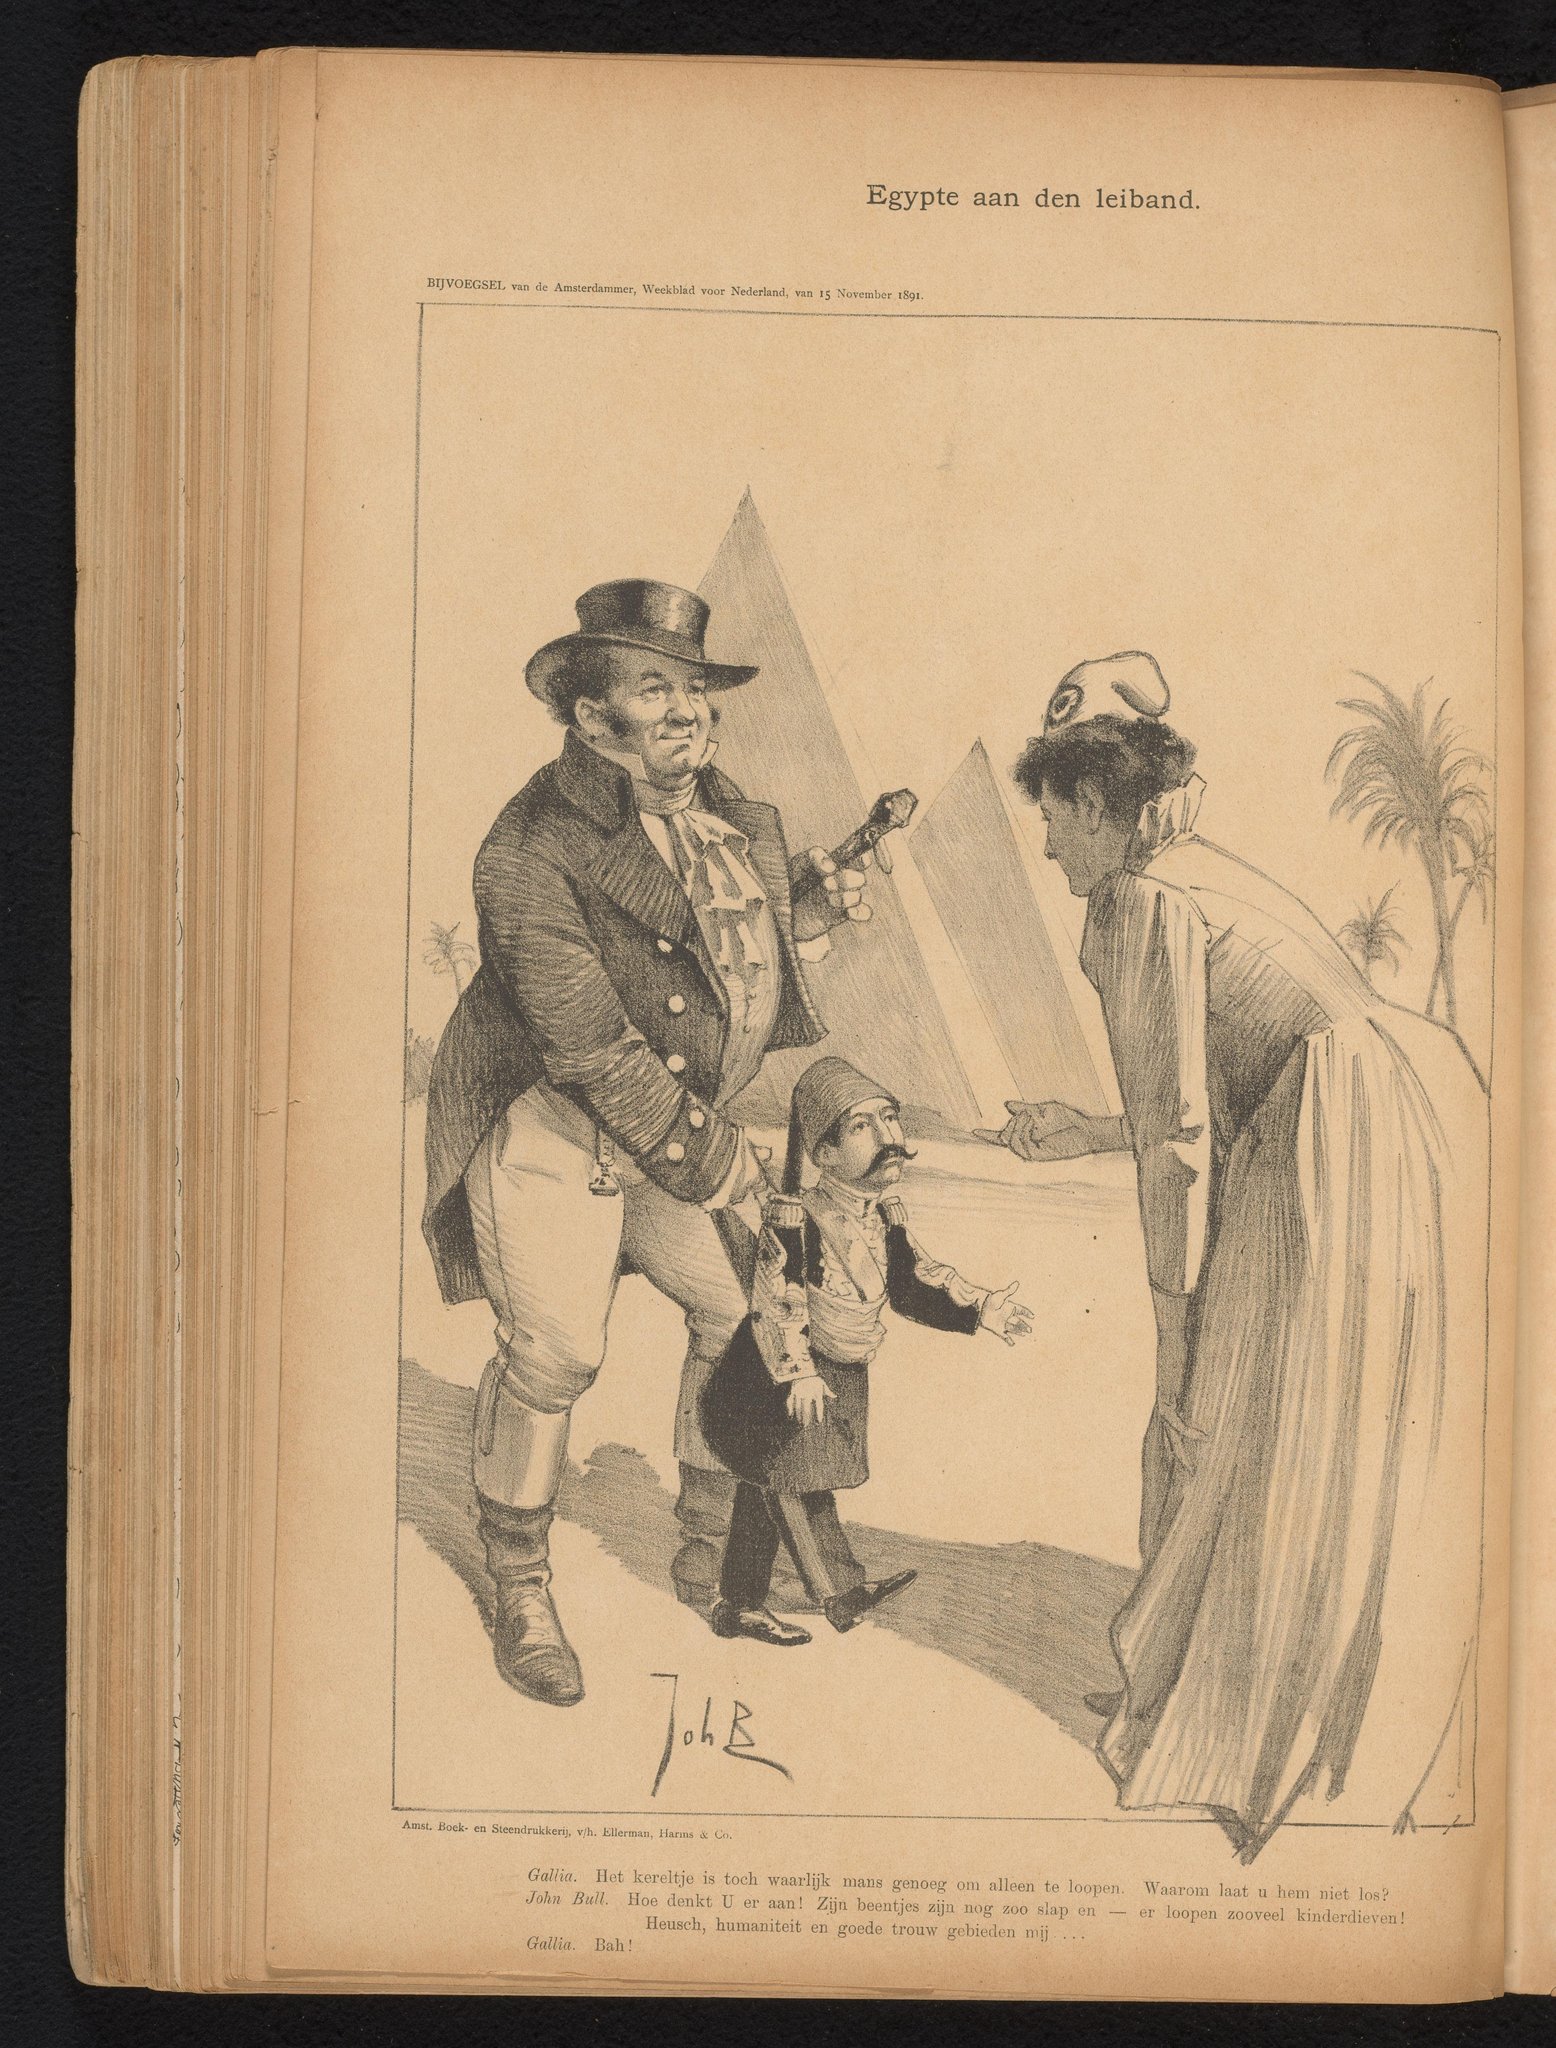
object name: cartoon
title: Egypte aan den leiband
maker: johan braakensiek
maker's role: draughtsman, print maker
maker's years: 1858-1940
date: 1891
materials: paper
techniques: lithograph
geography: amsterdam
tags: personifications of countries, nations, states, districts, etc. (+ nation; national), infant, baby, colonial government, political caricatures and satires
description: John Bull (Engeland) houdt kedive Abbas II van Egypte als een kind aan de leiband, dit tot verrassing van Gallia (Frankrijk). Op de achtergrond de piramiden van Gizeh. Egypte viel van 1882 tot 1952 onder Brits bestuur.